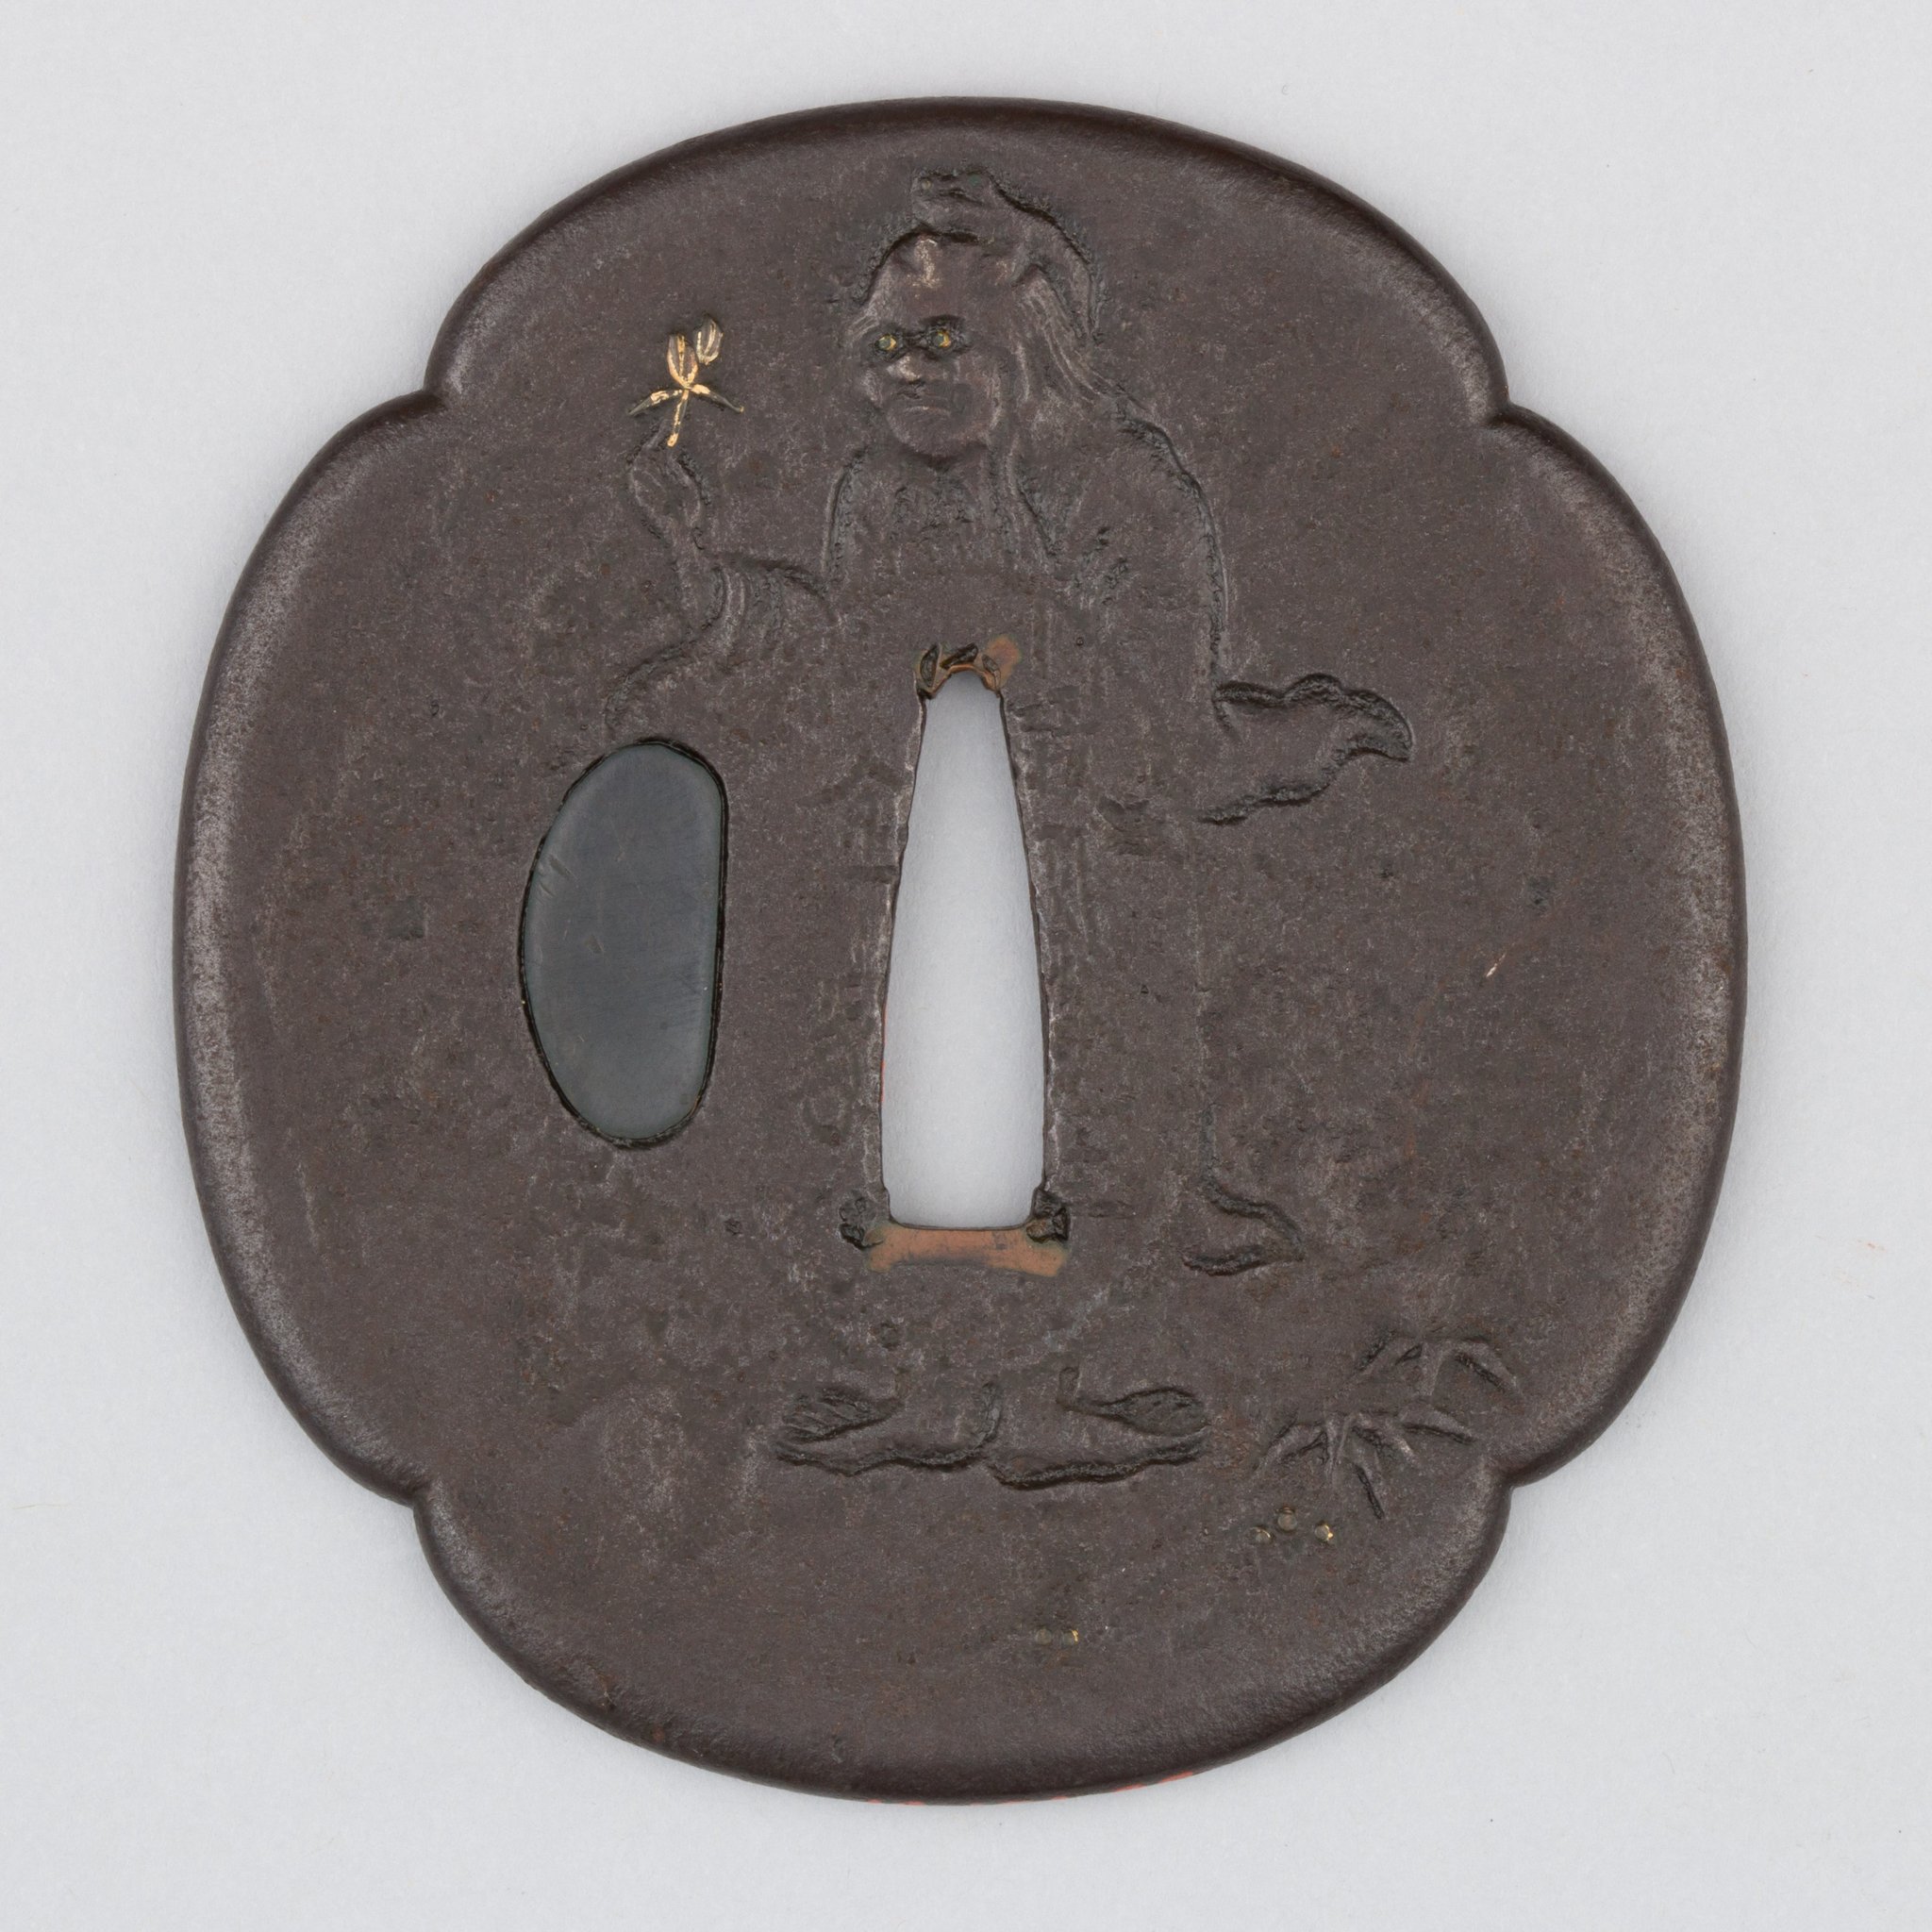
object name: sword guard tsuba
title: Sword Guard (Tsuba)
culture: japanese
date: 1701-1800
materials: copper, iron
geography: japan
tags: men